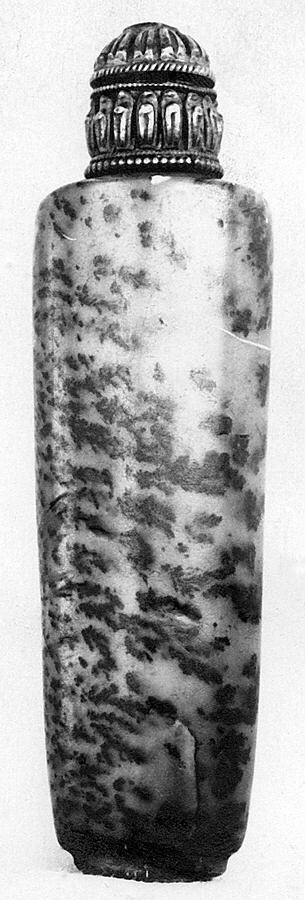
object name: snuff bottle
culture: chinese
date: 1801-1900